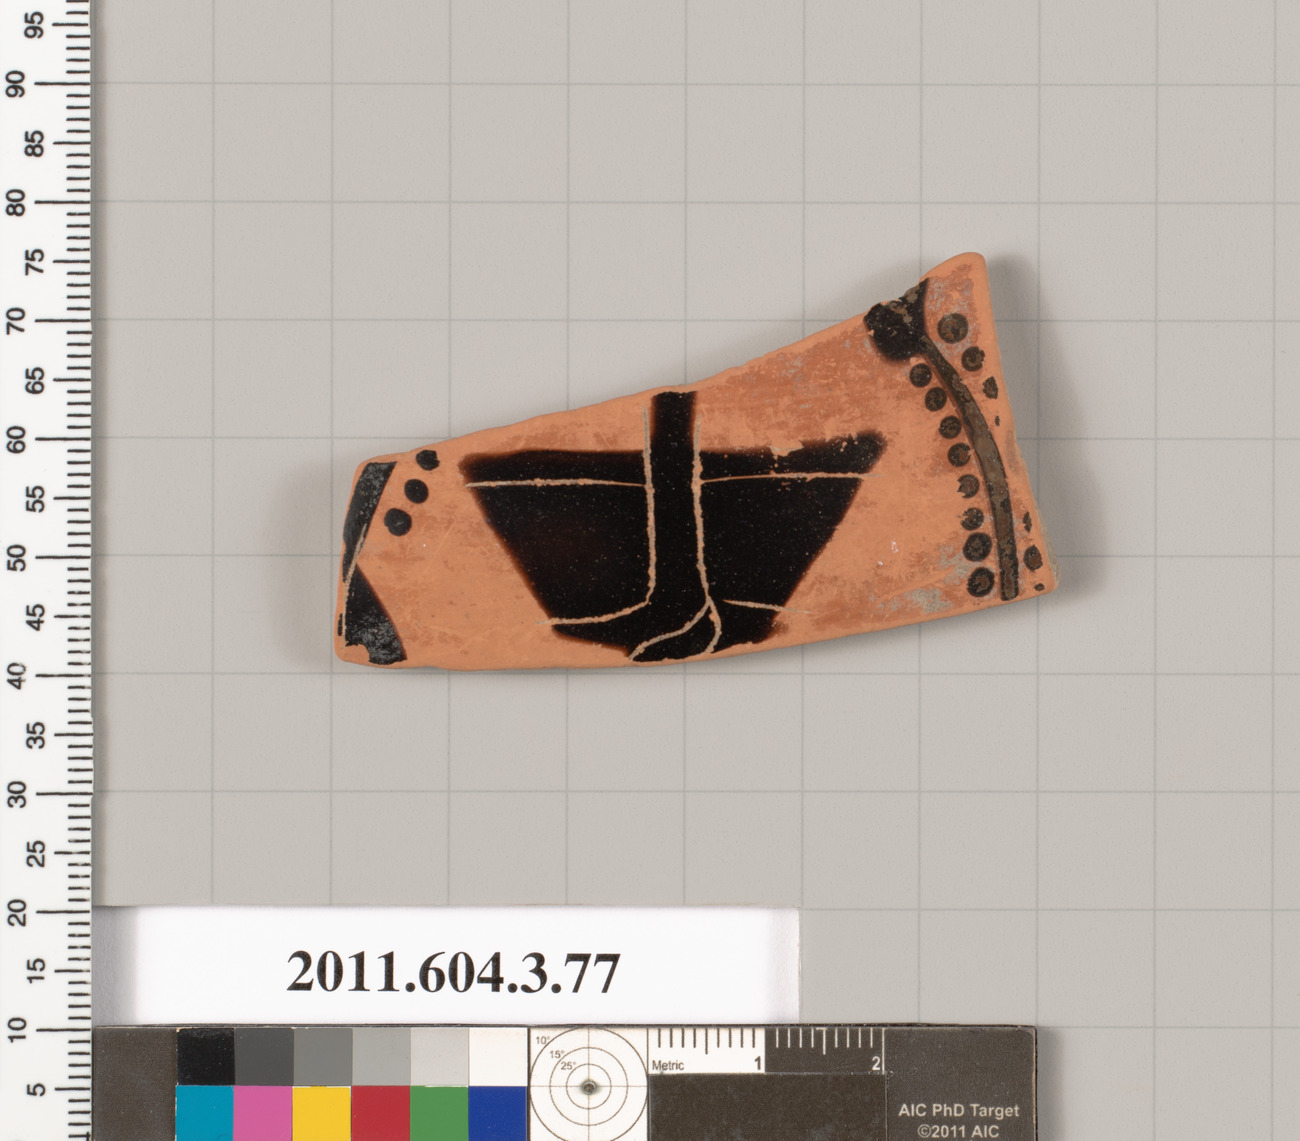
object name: amphora fragment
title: Terracotta fragment of an amphora (jar)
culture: greek, attic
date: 534-468 BCE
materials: terracotta